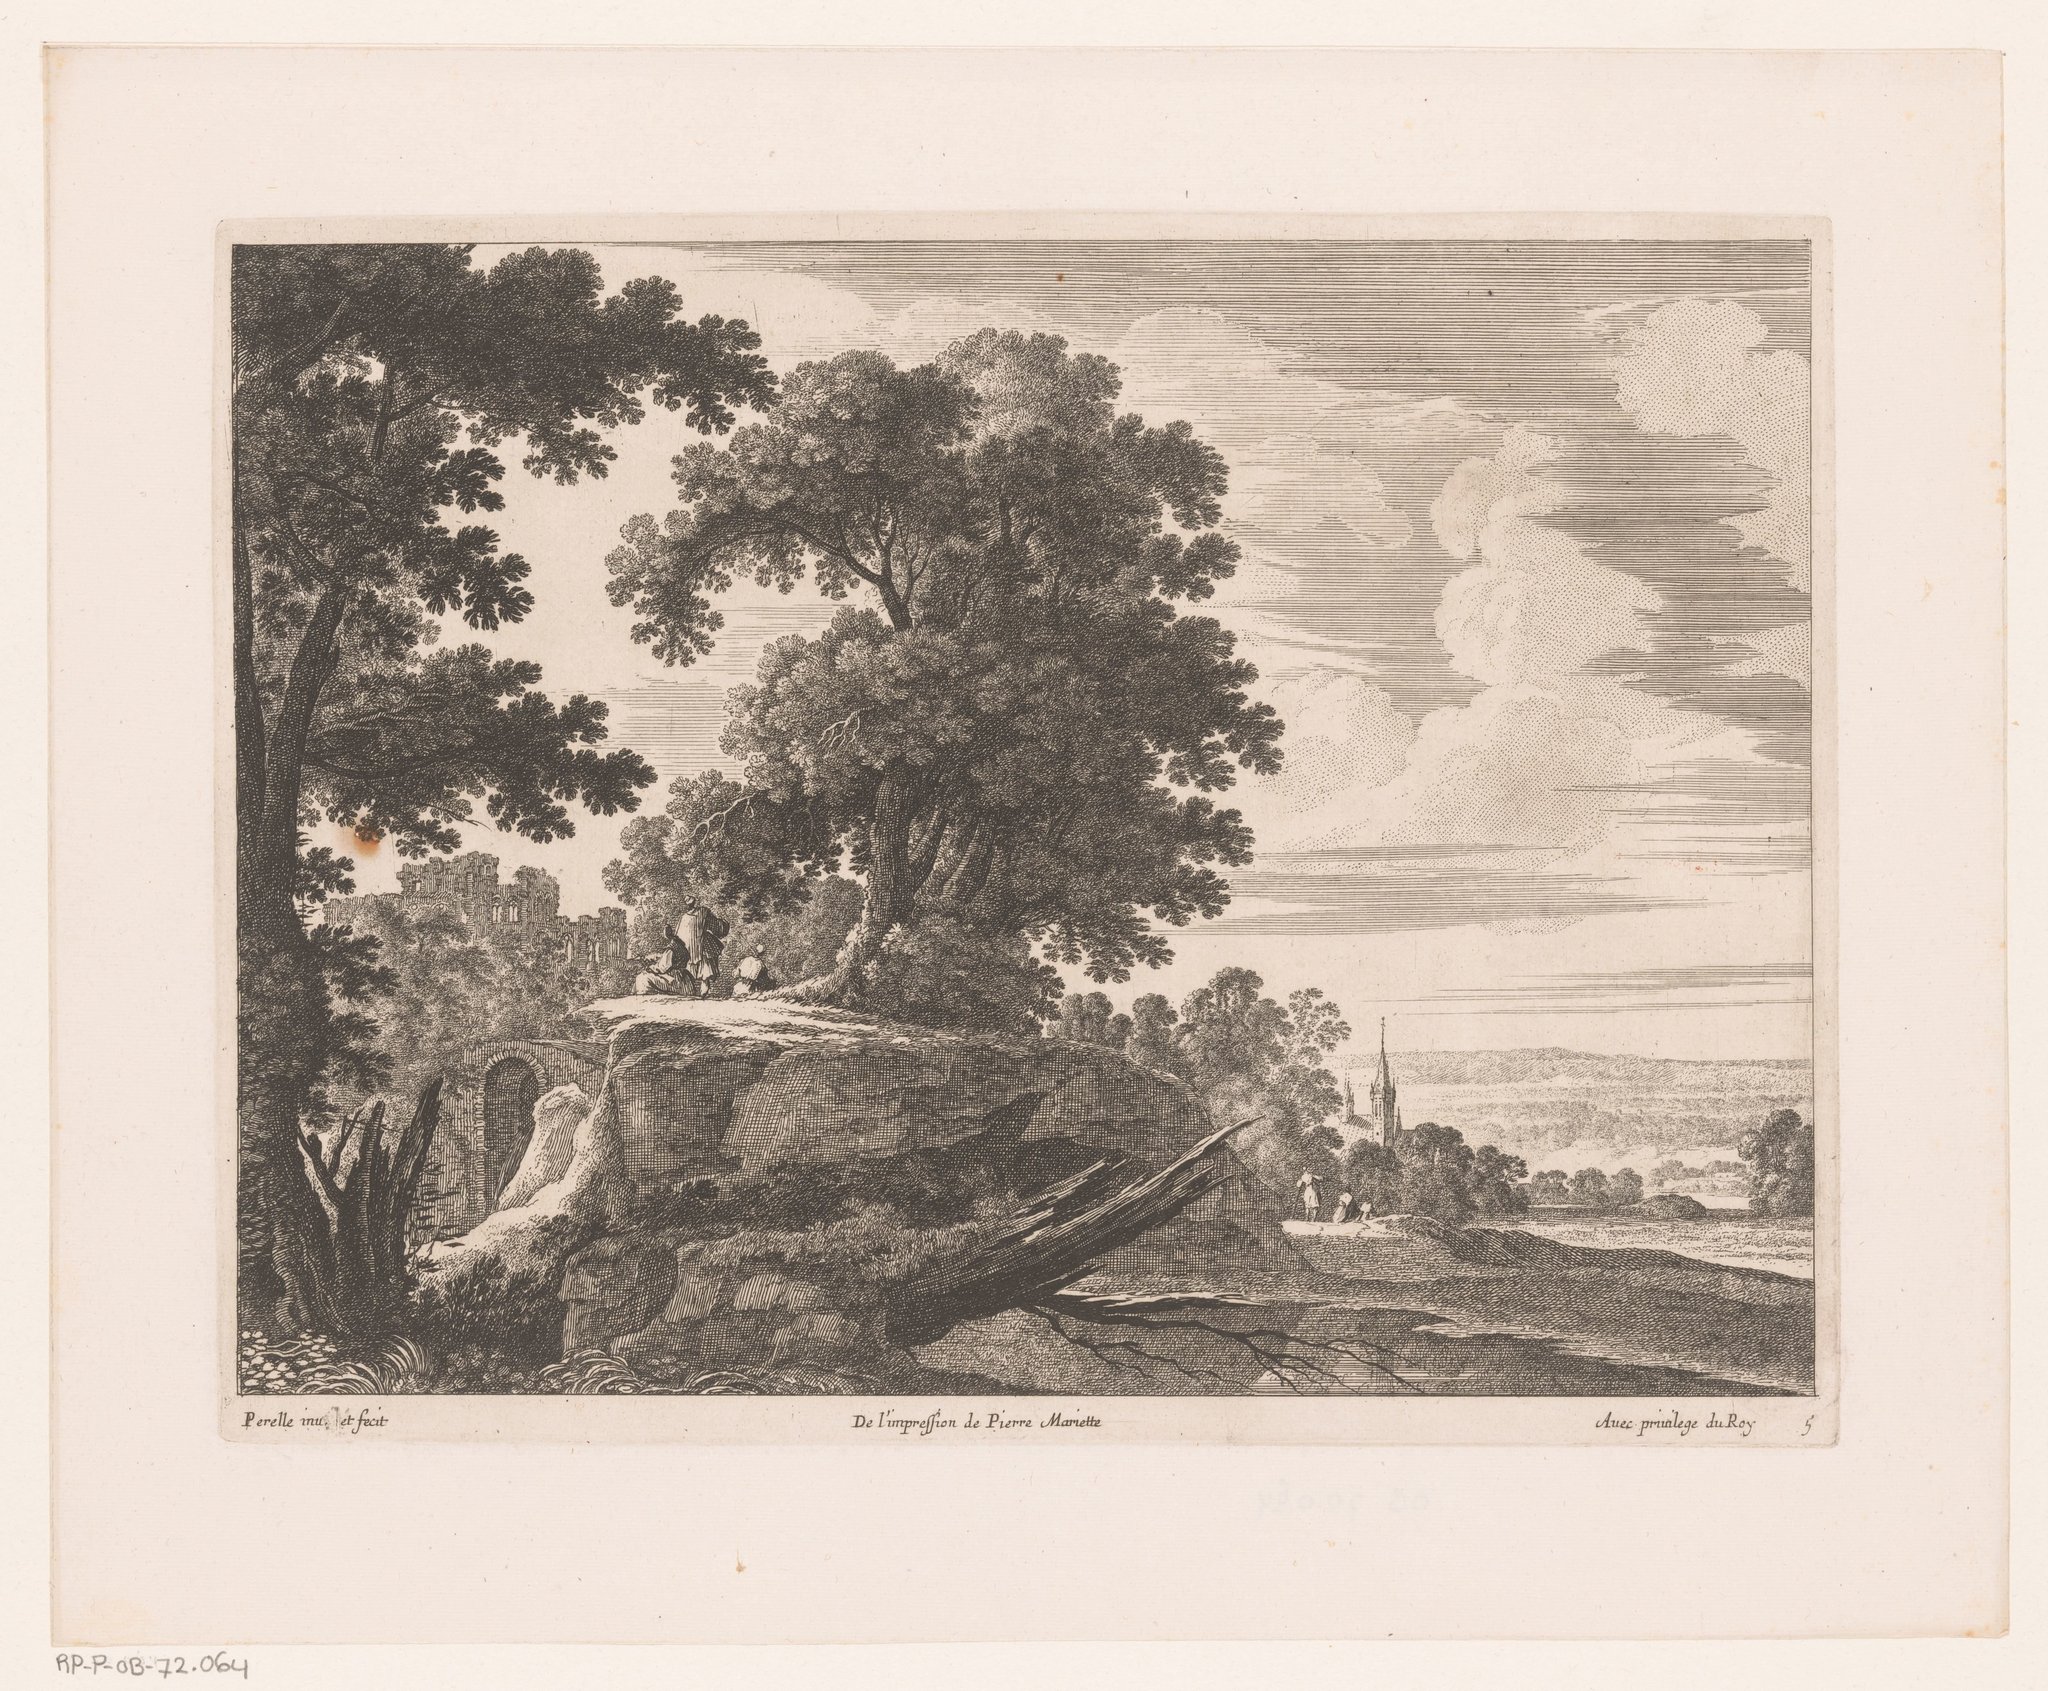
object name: print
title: Rivierlandschappen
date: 1613-1695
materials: paper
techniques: engraving, etching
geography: france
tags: low hill country (+ landscape with figures, staffage)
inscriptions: collector's mark: Lugt 240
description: Prenten met het signatuur 'Perelle' kunnen zowel door vader Gabriel als door zonen Nicolas en Adam gemaakt zijn.